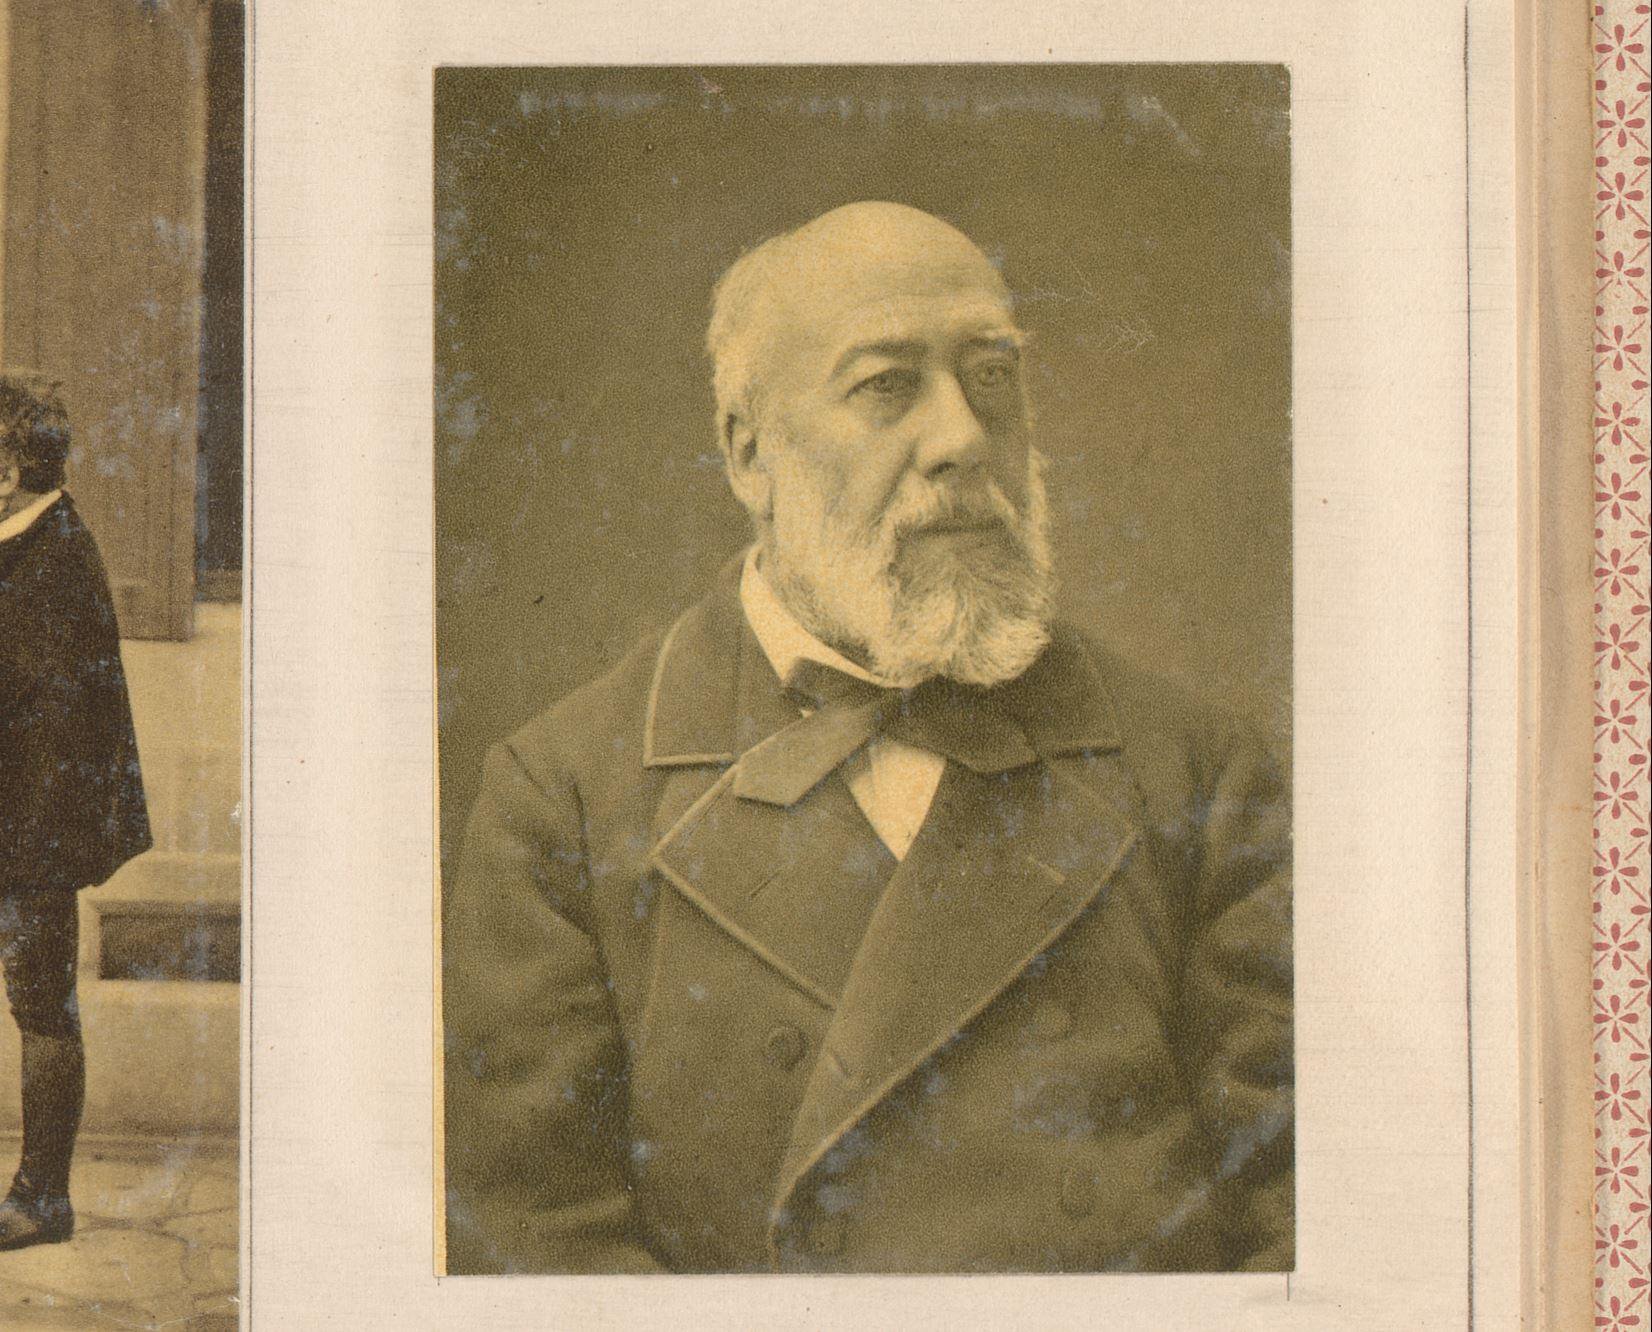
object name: album leaf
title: Gustave Nadaud (en 1880)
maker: Anonymous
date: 1880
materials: paper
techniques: rotogravure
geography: france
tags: portrait of a musician, france